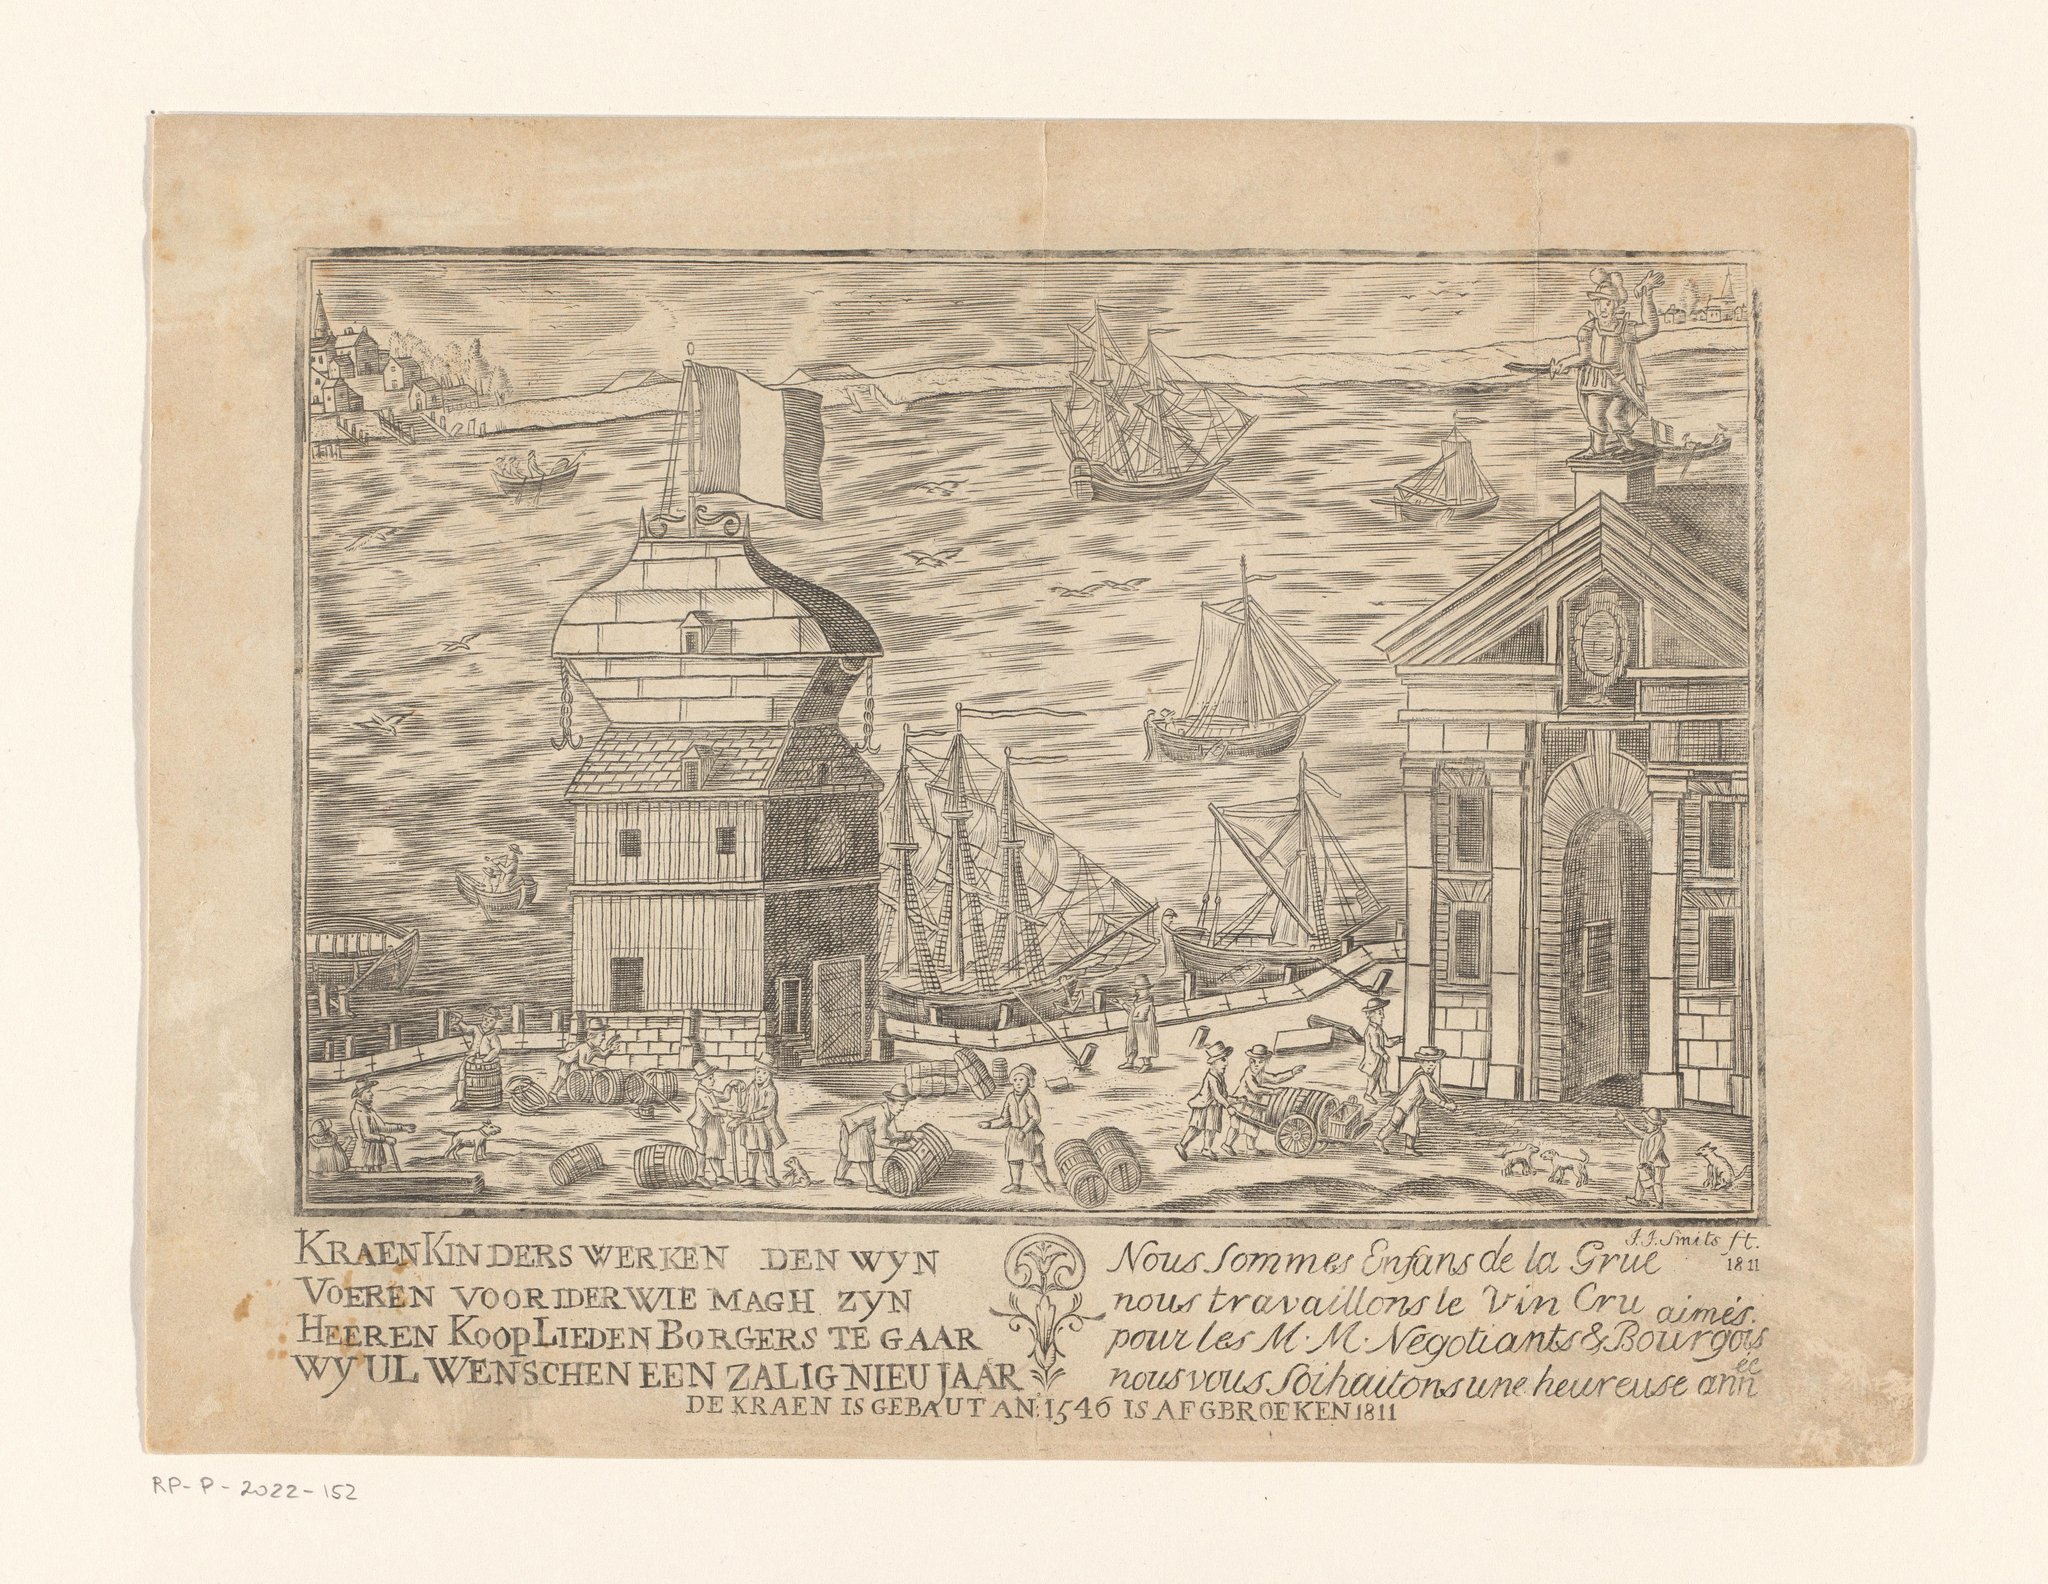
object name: print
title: Nieuwjaarswens voor 1811 van de Antwerpse kraankinderen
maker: j.j. smits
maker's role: print maker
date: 1811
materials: paper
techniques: engraving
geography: antwerp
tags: dock crane, city-gate, quay, antwerp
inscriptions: collector's mark: Lugt 2228, collector's mark: Lugt 2760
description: Het Antwerpse Kranenhoofd en de Werfpoort, met een zicht op de Schelde erachter. Onderaan twee vierregelige verzen in het Nederlands en in het Frans.